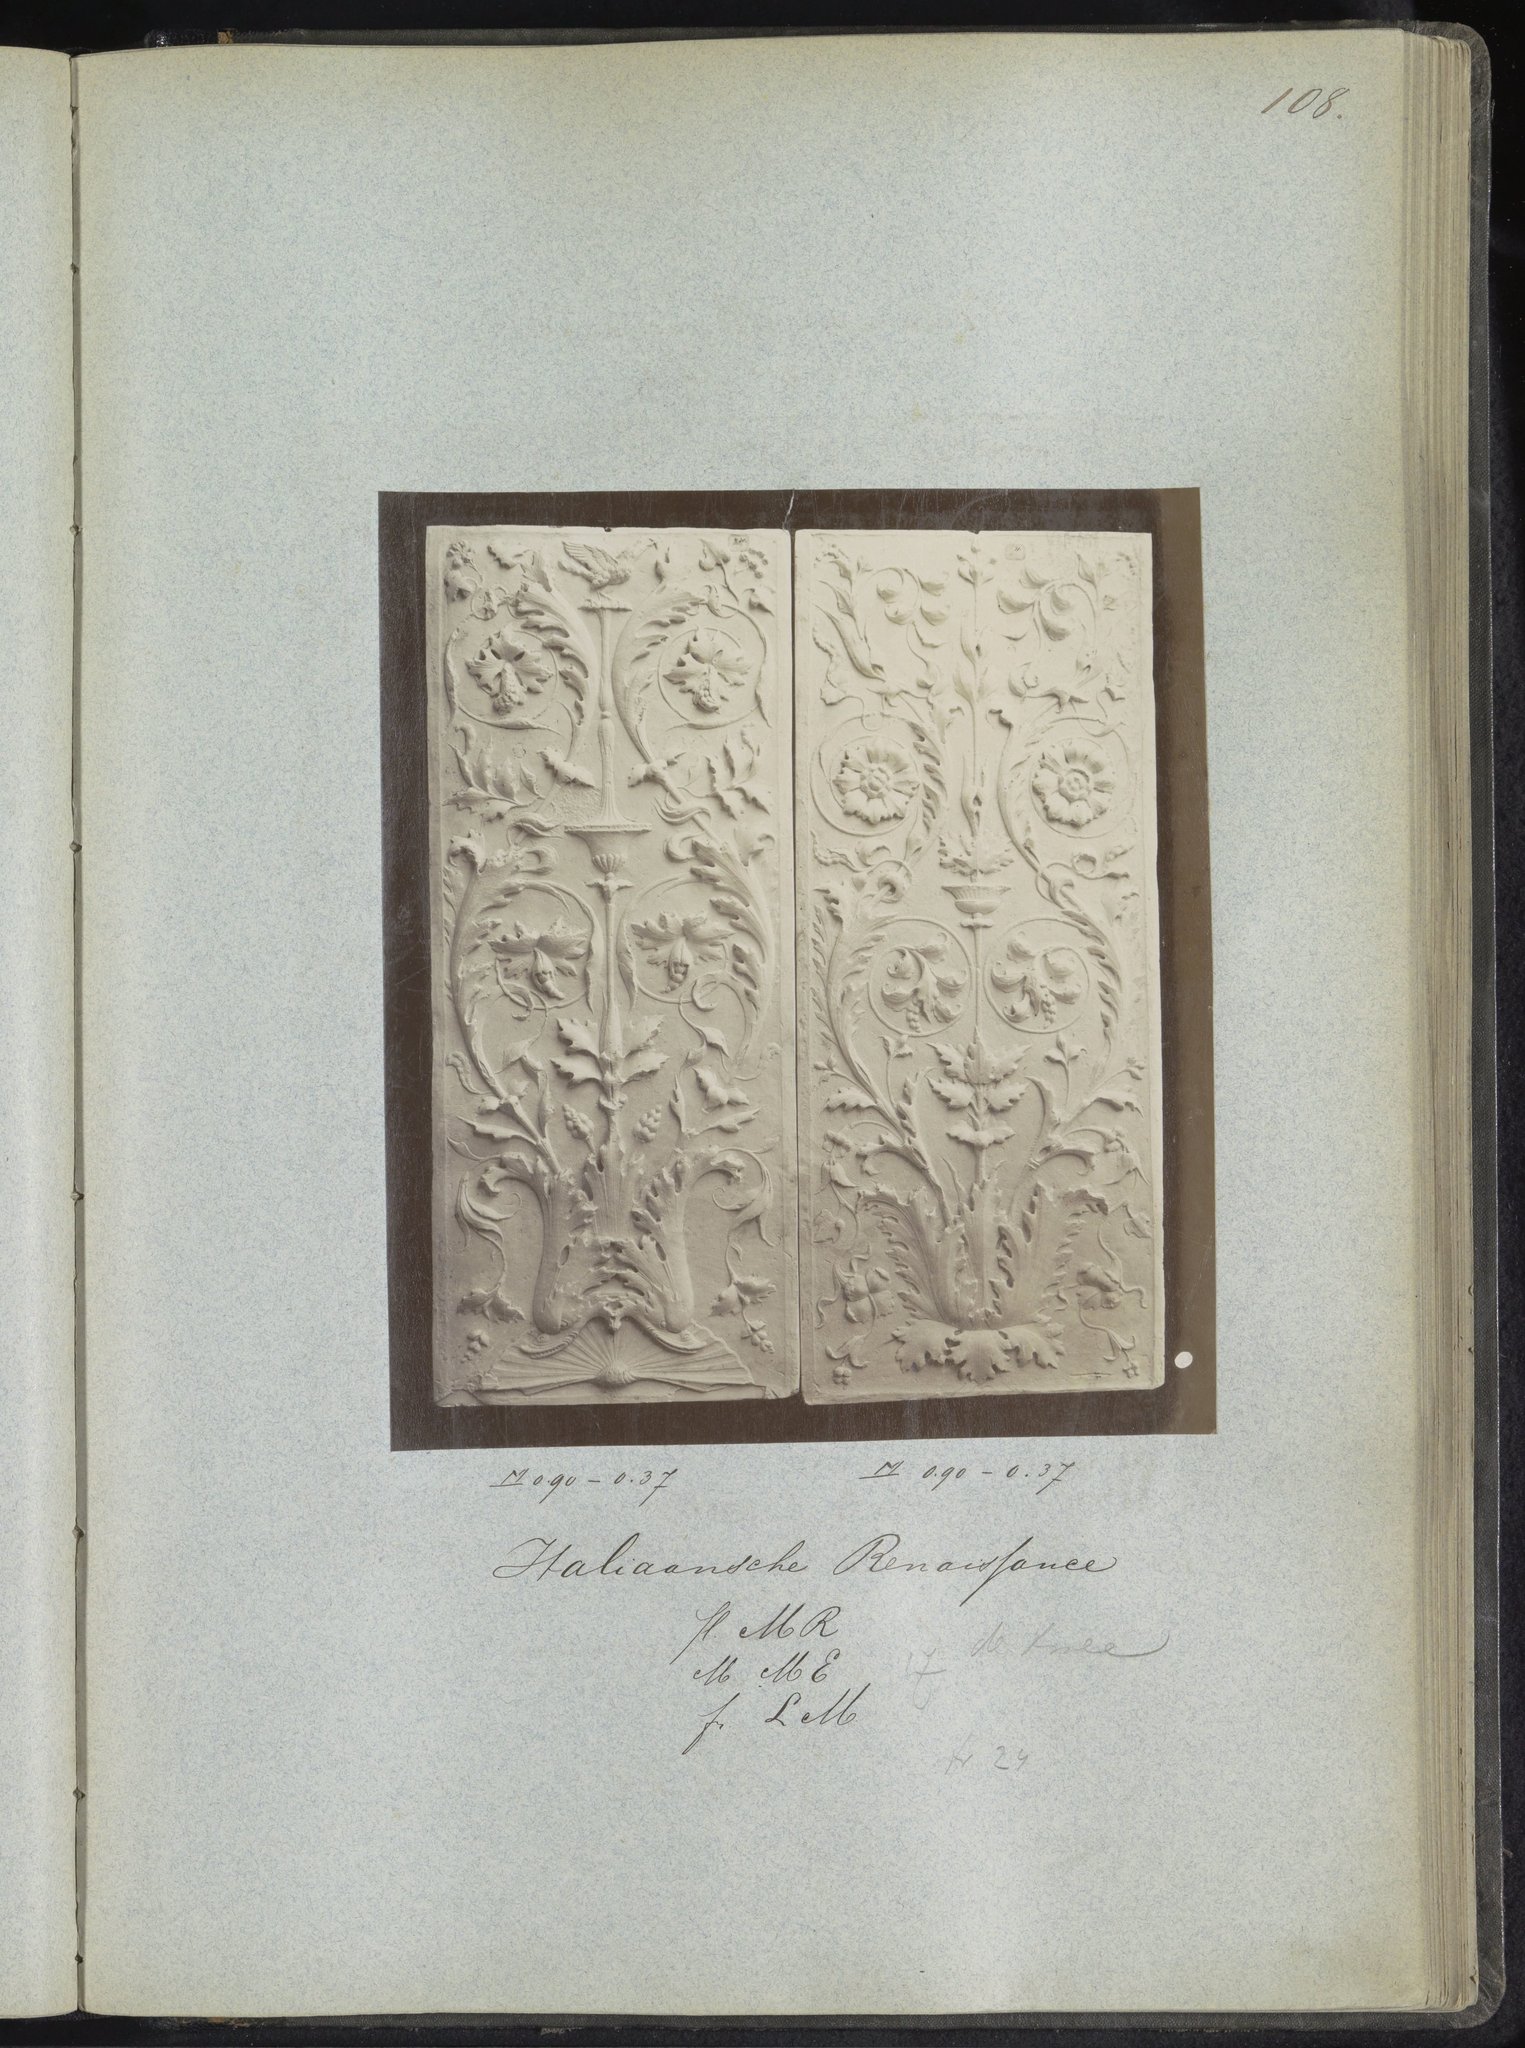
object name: photograph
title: Gipsen afgietsels van panelen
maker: Anonymous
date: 1875-1900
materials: paper, photographic support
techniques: albumen print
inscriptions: annotation: ‘M 0.90-0.37 M 0.90-0.37’, annotation: ‘Italiaansche Renaissance’, annotation